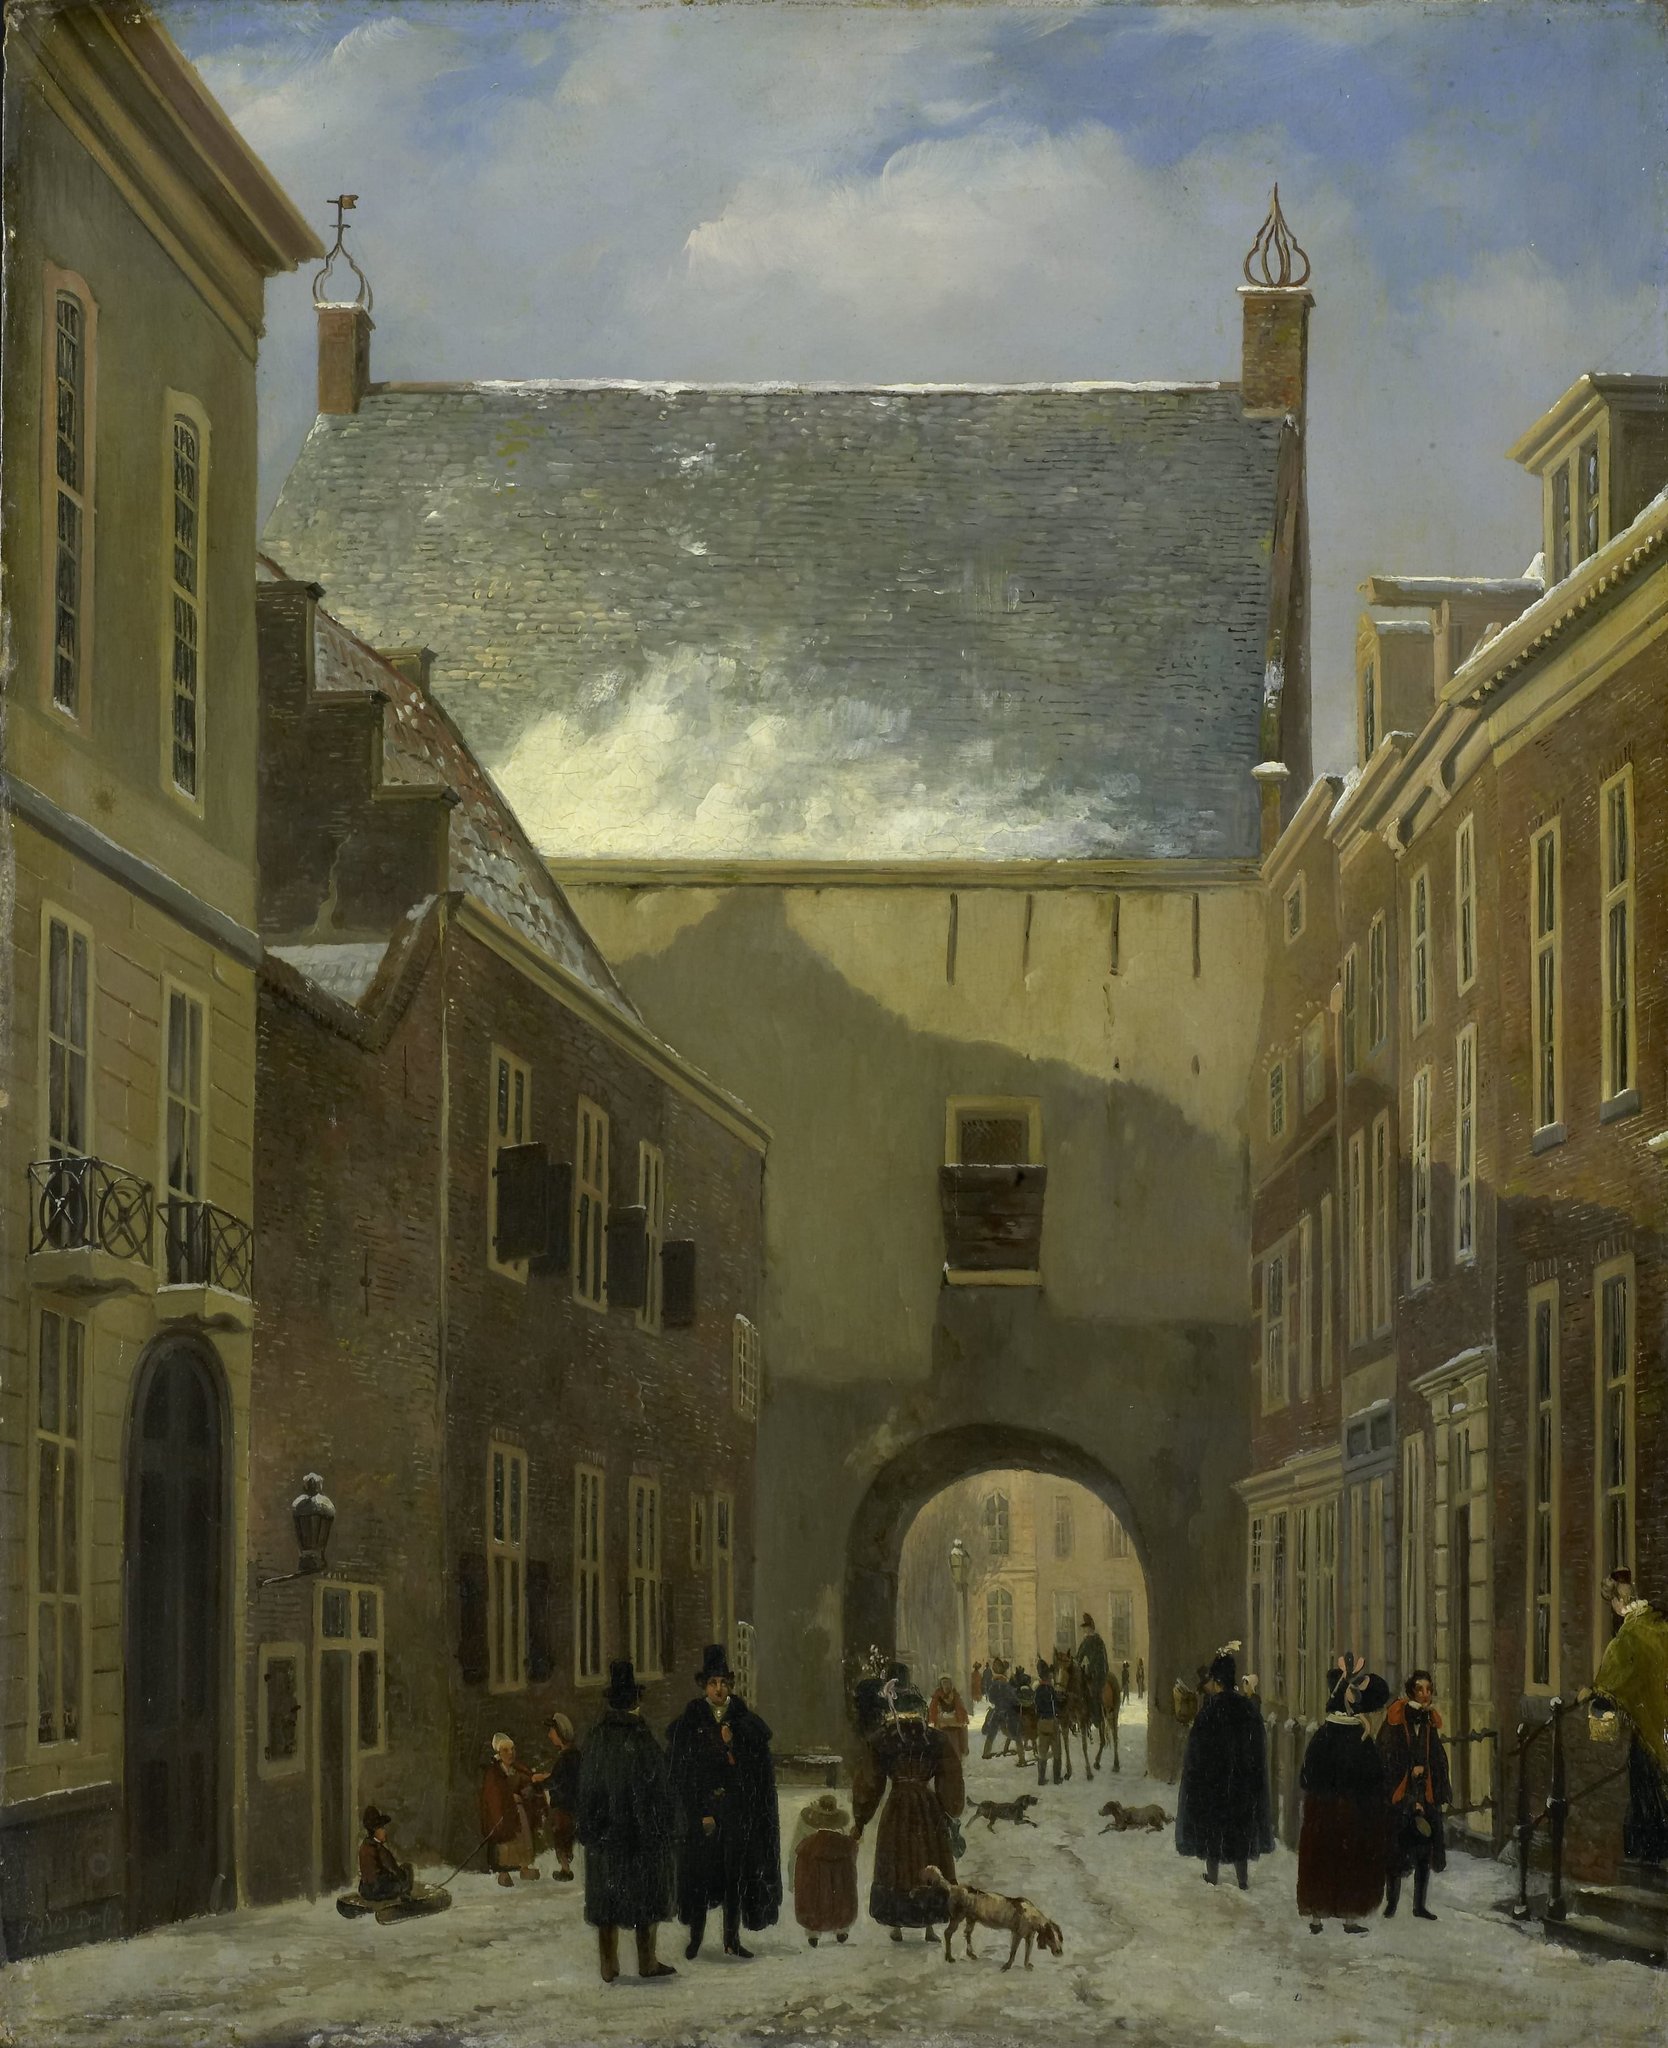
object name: painting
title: The Gevangenpoort (Prison Gate), The Hague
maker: johannes adrianus van der drift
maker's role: print maker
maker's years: 1808-1883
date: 1820-1830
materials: oil, panel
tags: prison, jail, snow, city-gate, playing with snow and ice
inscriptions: signature: ‘J.A. v.d. Drift’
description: De Gevangenpoort te Den Haag in de winter. Voetgangers op straat en spelende kinderen in de sneeuw.